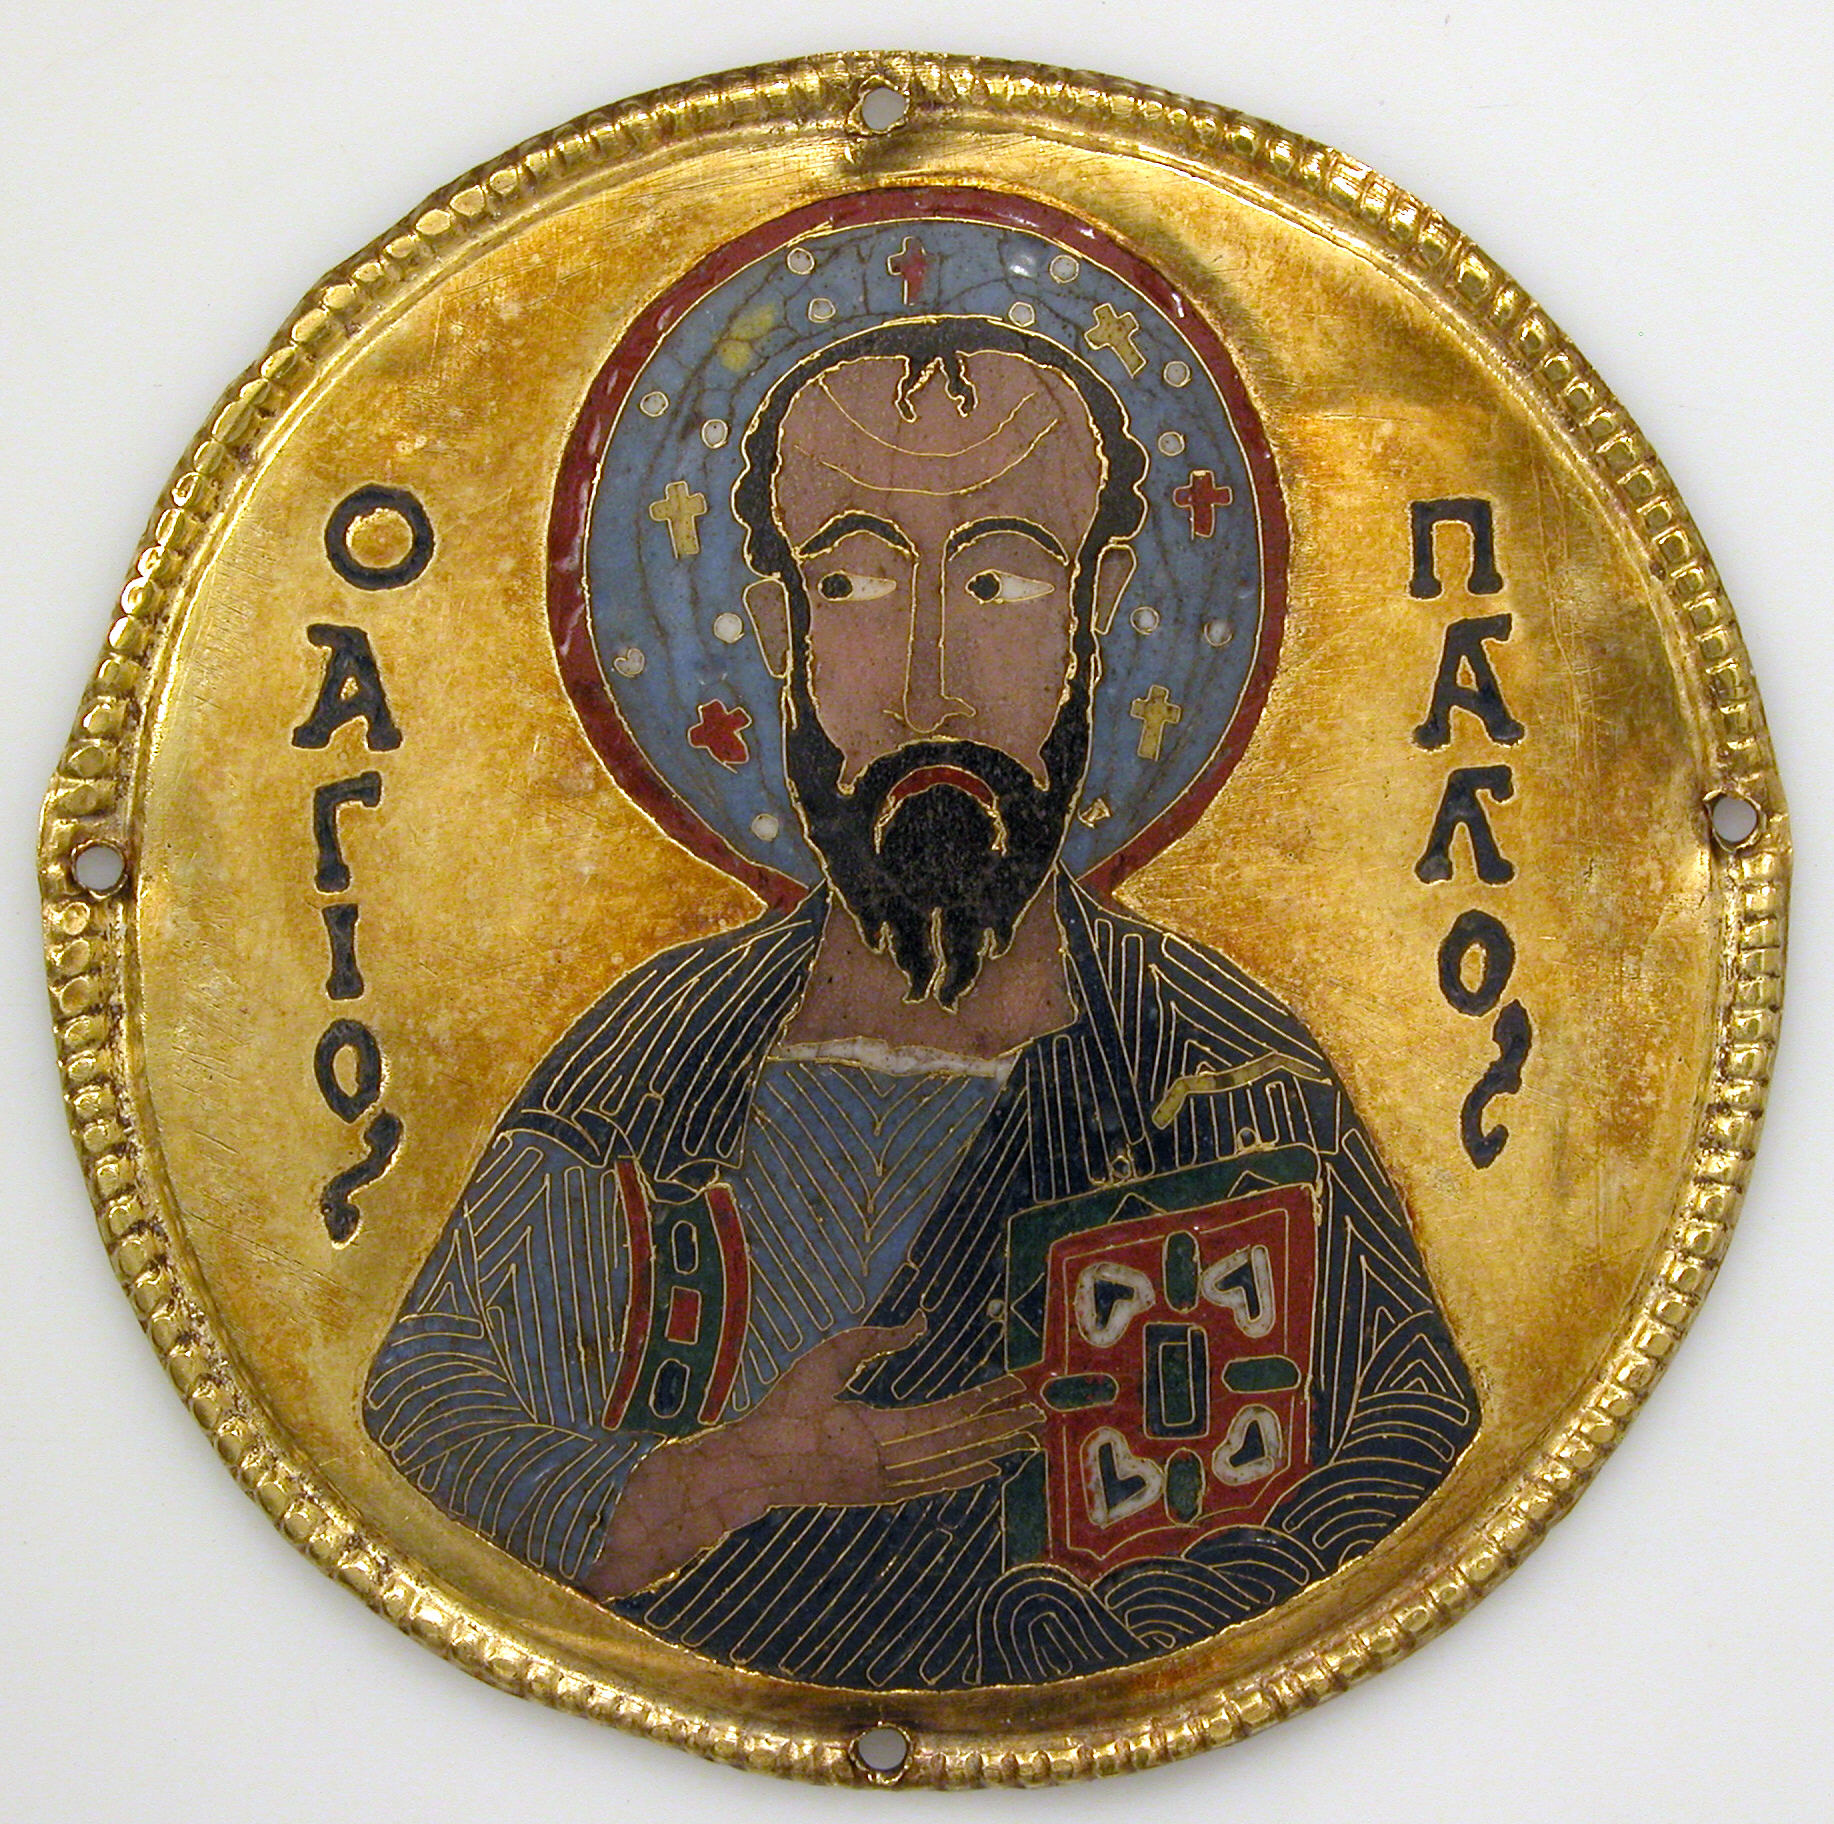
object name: medallion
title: Medallion with Saint Paul from an Icon Frame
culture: byzantine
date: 1100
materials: enamel, gold, silver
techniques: enamel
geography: constantinople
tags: saint paul